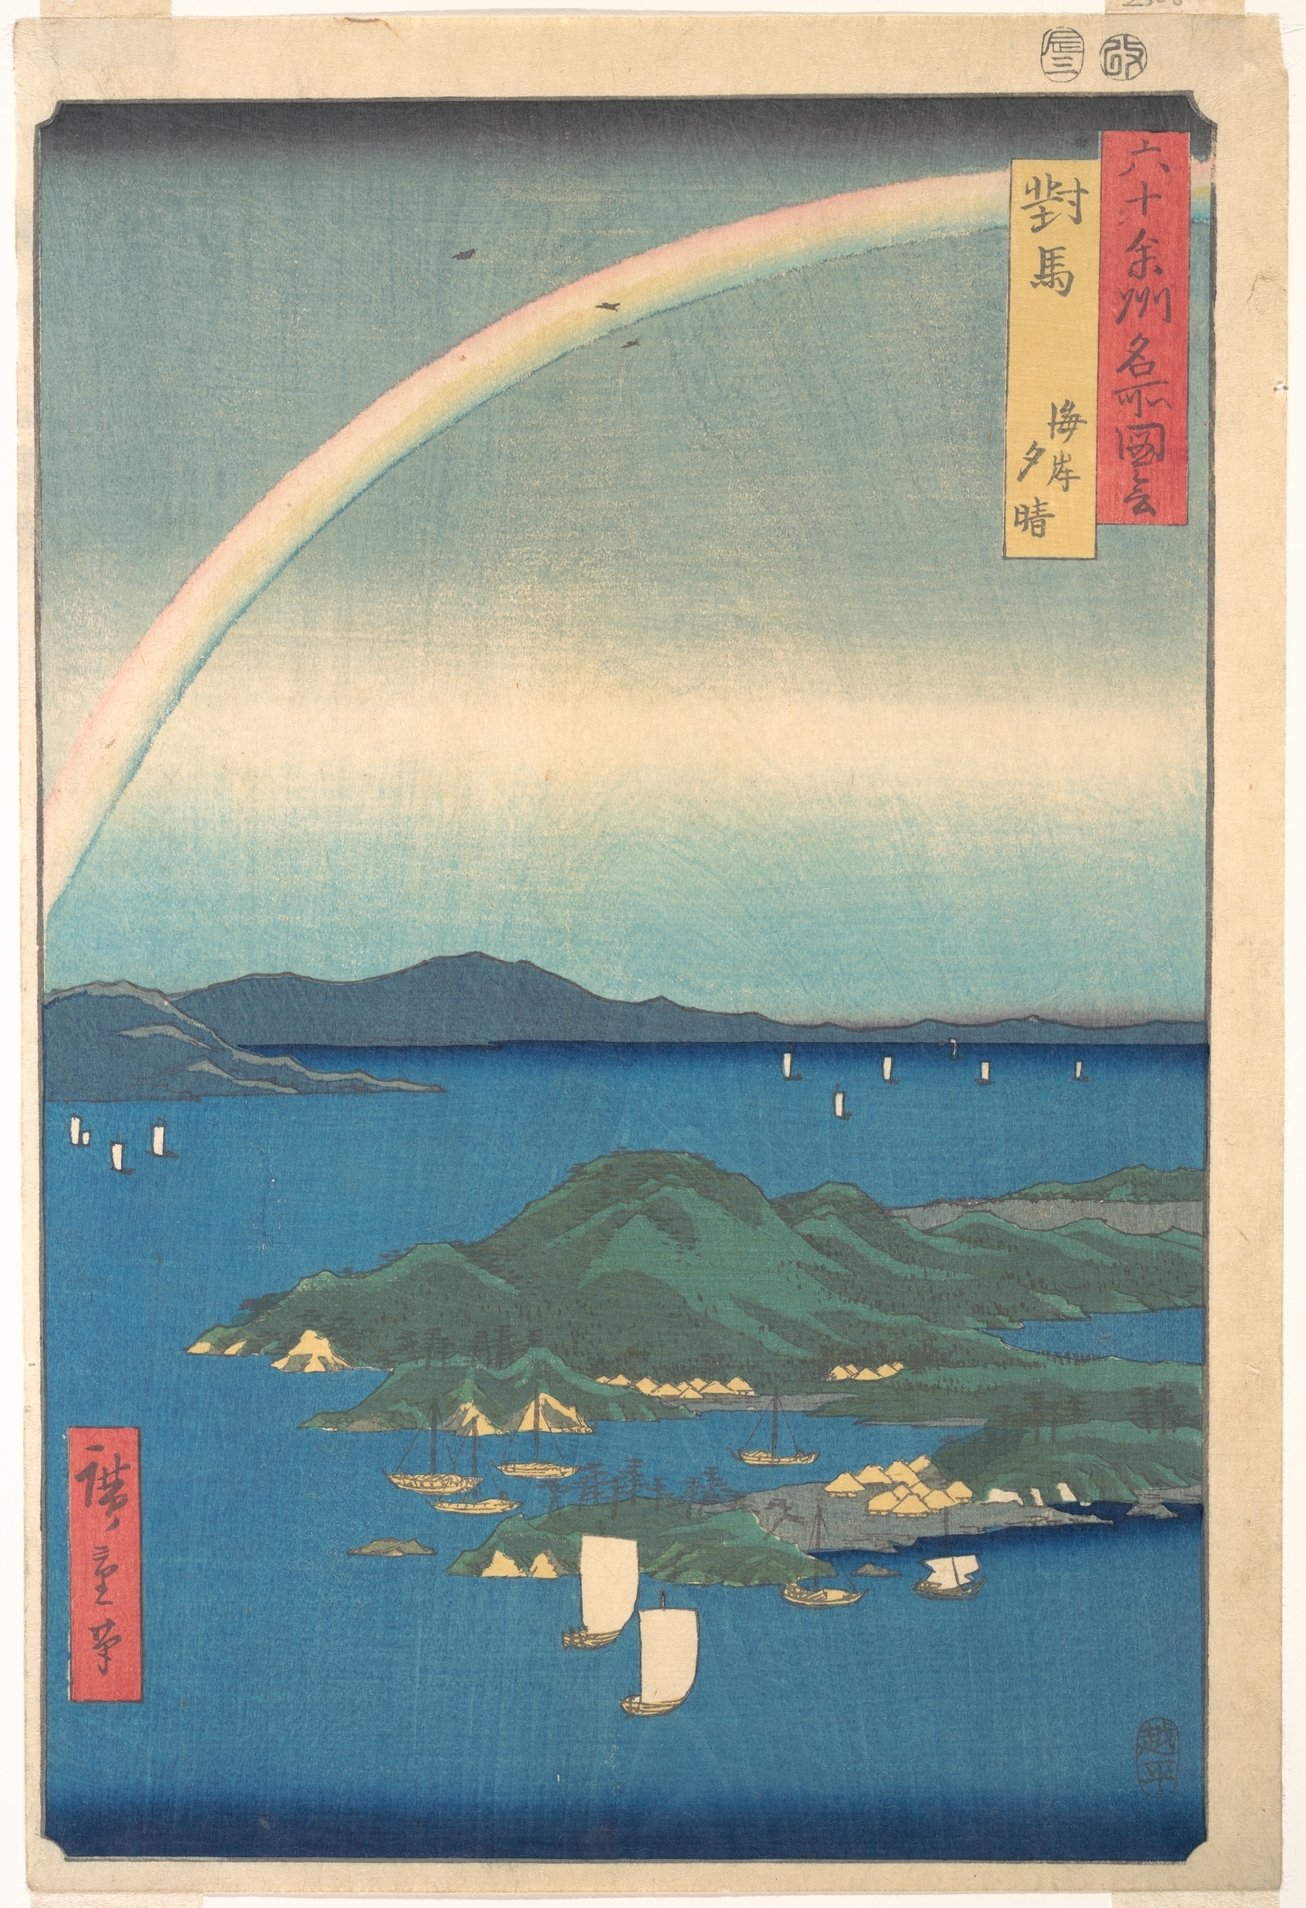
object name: woodblock print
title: Evening Glow, Tsushima Province , from the series Views of Famous Places in the Sixty-Odd Provinces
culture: japanese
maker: utagawa hiroshige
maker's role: artist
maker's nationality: japanese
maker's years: 1797-1858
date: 1853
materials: ink, paper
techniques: woodblock print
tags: landscapes,boats,rainbows